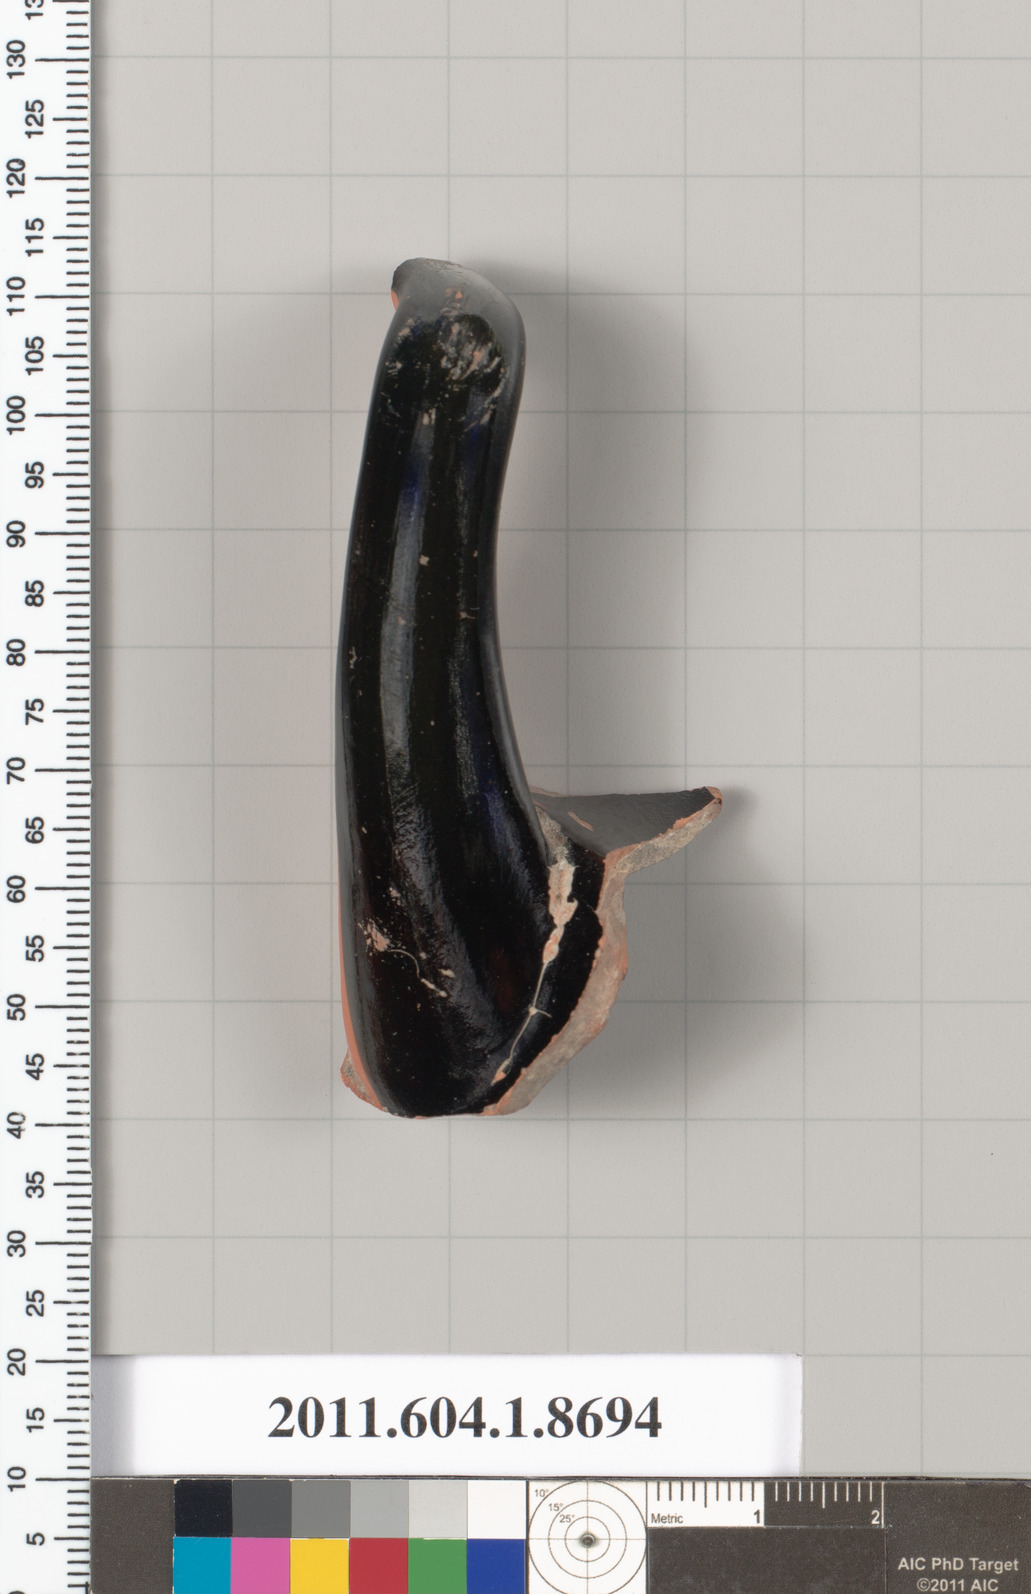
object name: kylix fragment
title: Terracotta fragment of a stemless kylix (drinking cup)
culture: greek, attic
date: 470-450 BCE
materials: terracotta